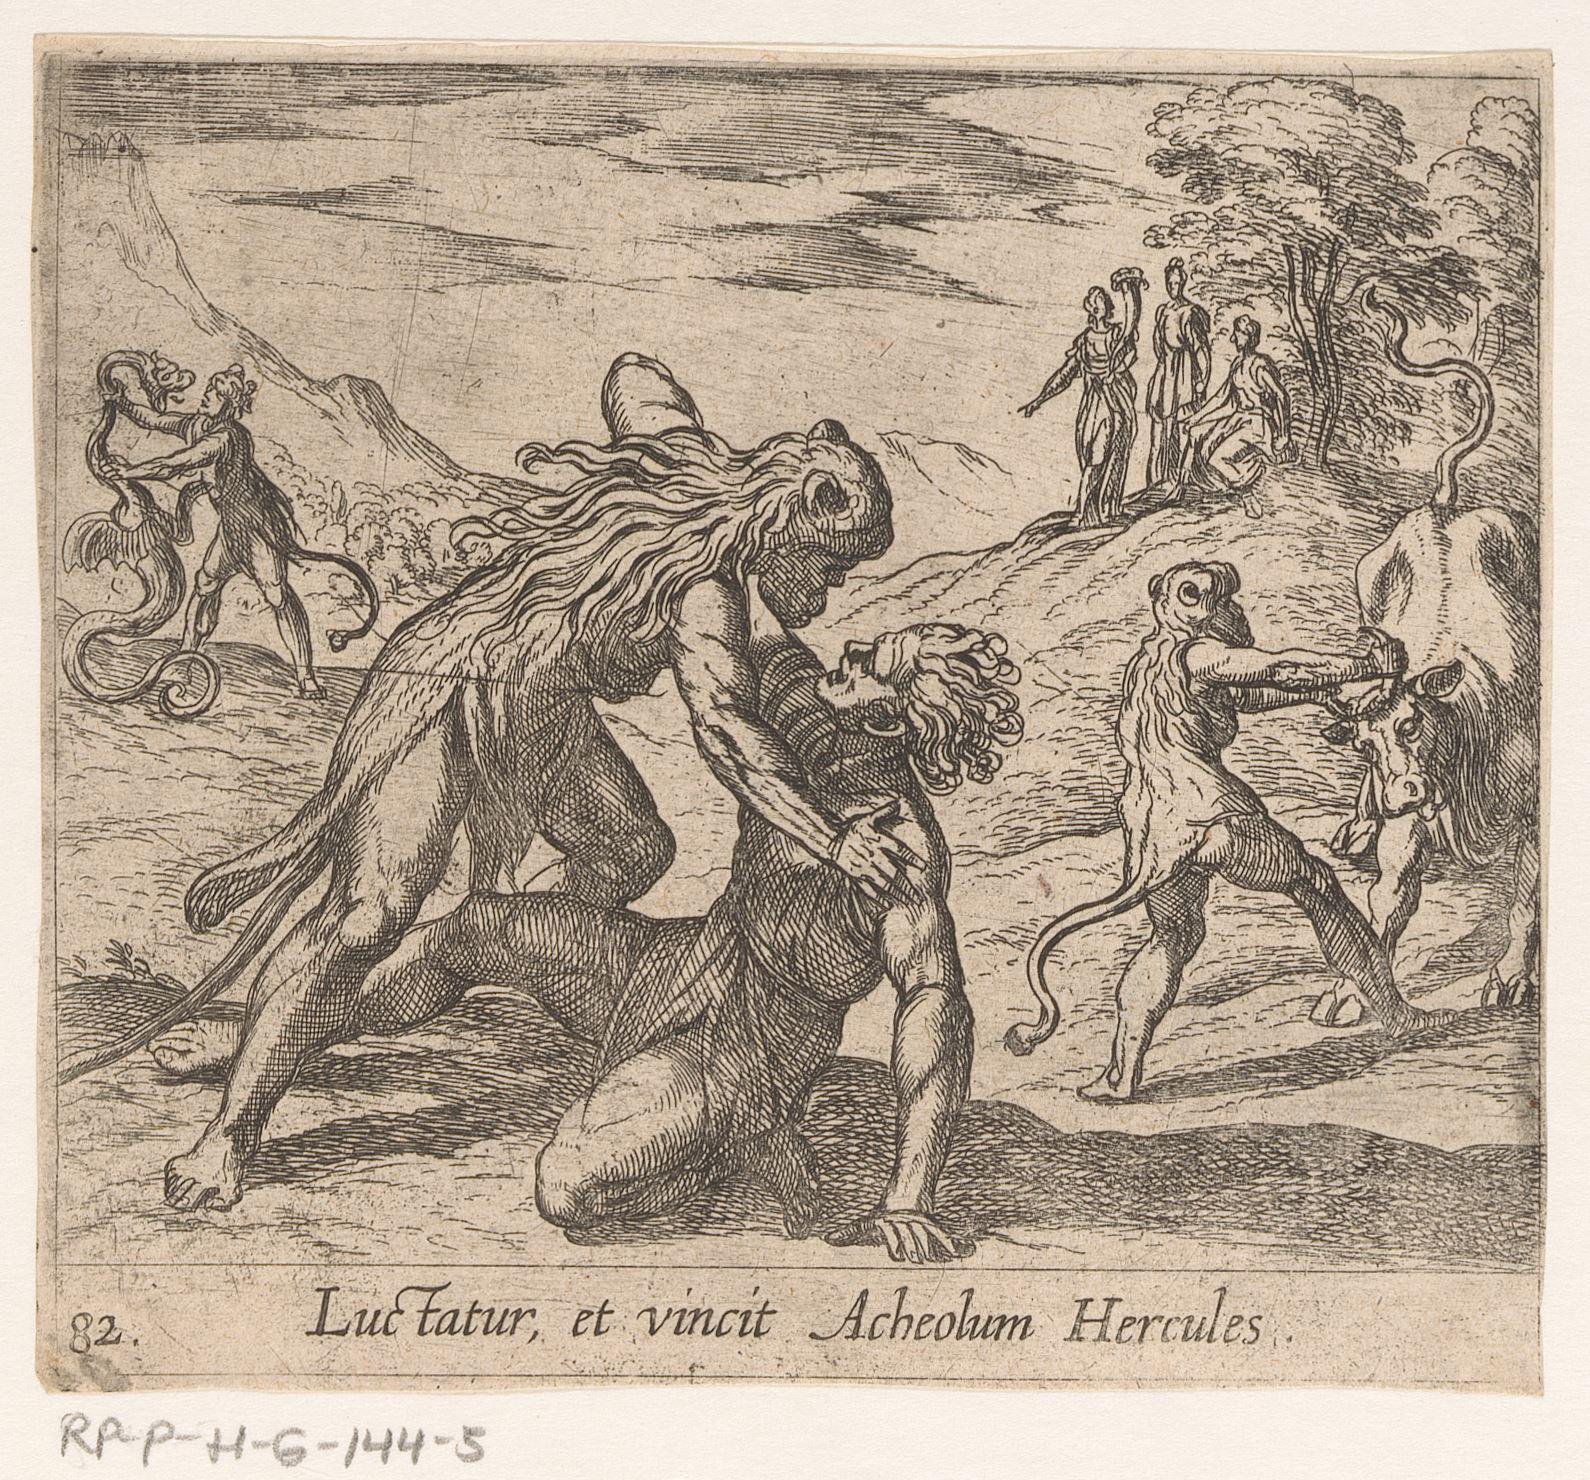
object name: print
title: Hercules worstelt met Acheloüs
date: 1606-1638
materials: paper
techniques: etching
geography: amsterdam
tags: while fighting with hercules the river-god achelous changes himself into a serpent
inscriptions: collector's mark: ‘Hinloopen’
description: Hercules in gevecht met de riviergod Acheloüs om Deïanira, de dochter van de riviergod Oeneus. Links heeft Acheloüs de gedaante aangenomen van een serpent. Rechts heeft hij de gedaante aangenomen van een stier. Op de voorgrond is hij in menselijke gedaante aan het worstelen met Hercules. Titel in het Latijn in ondermarge.